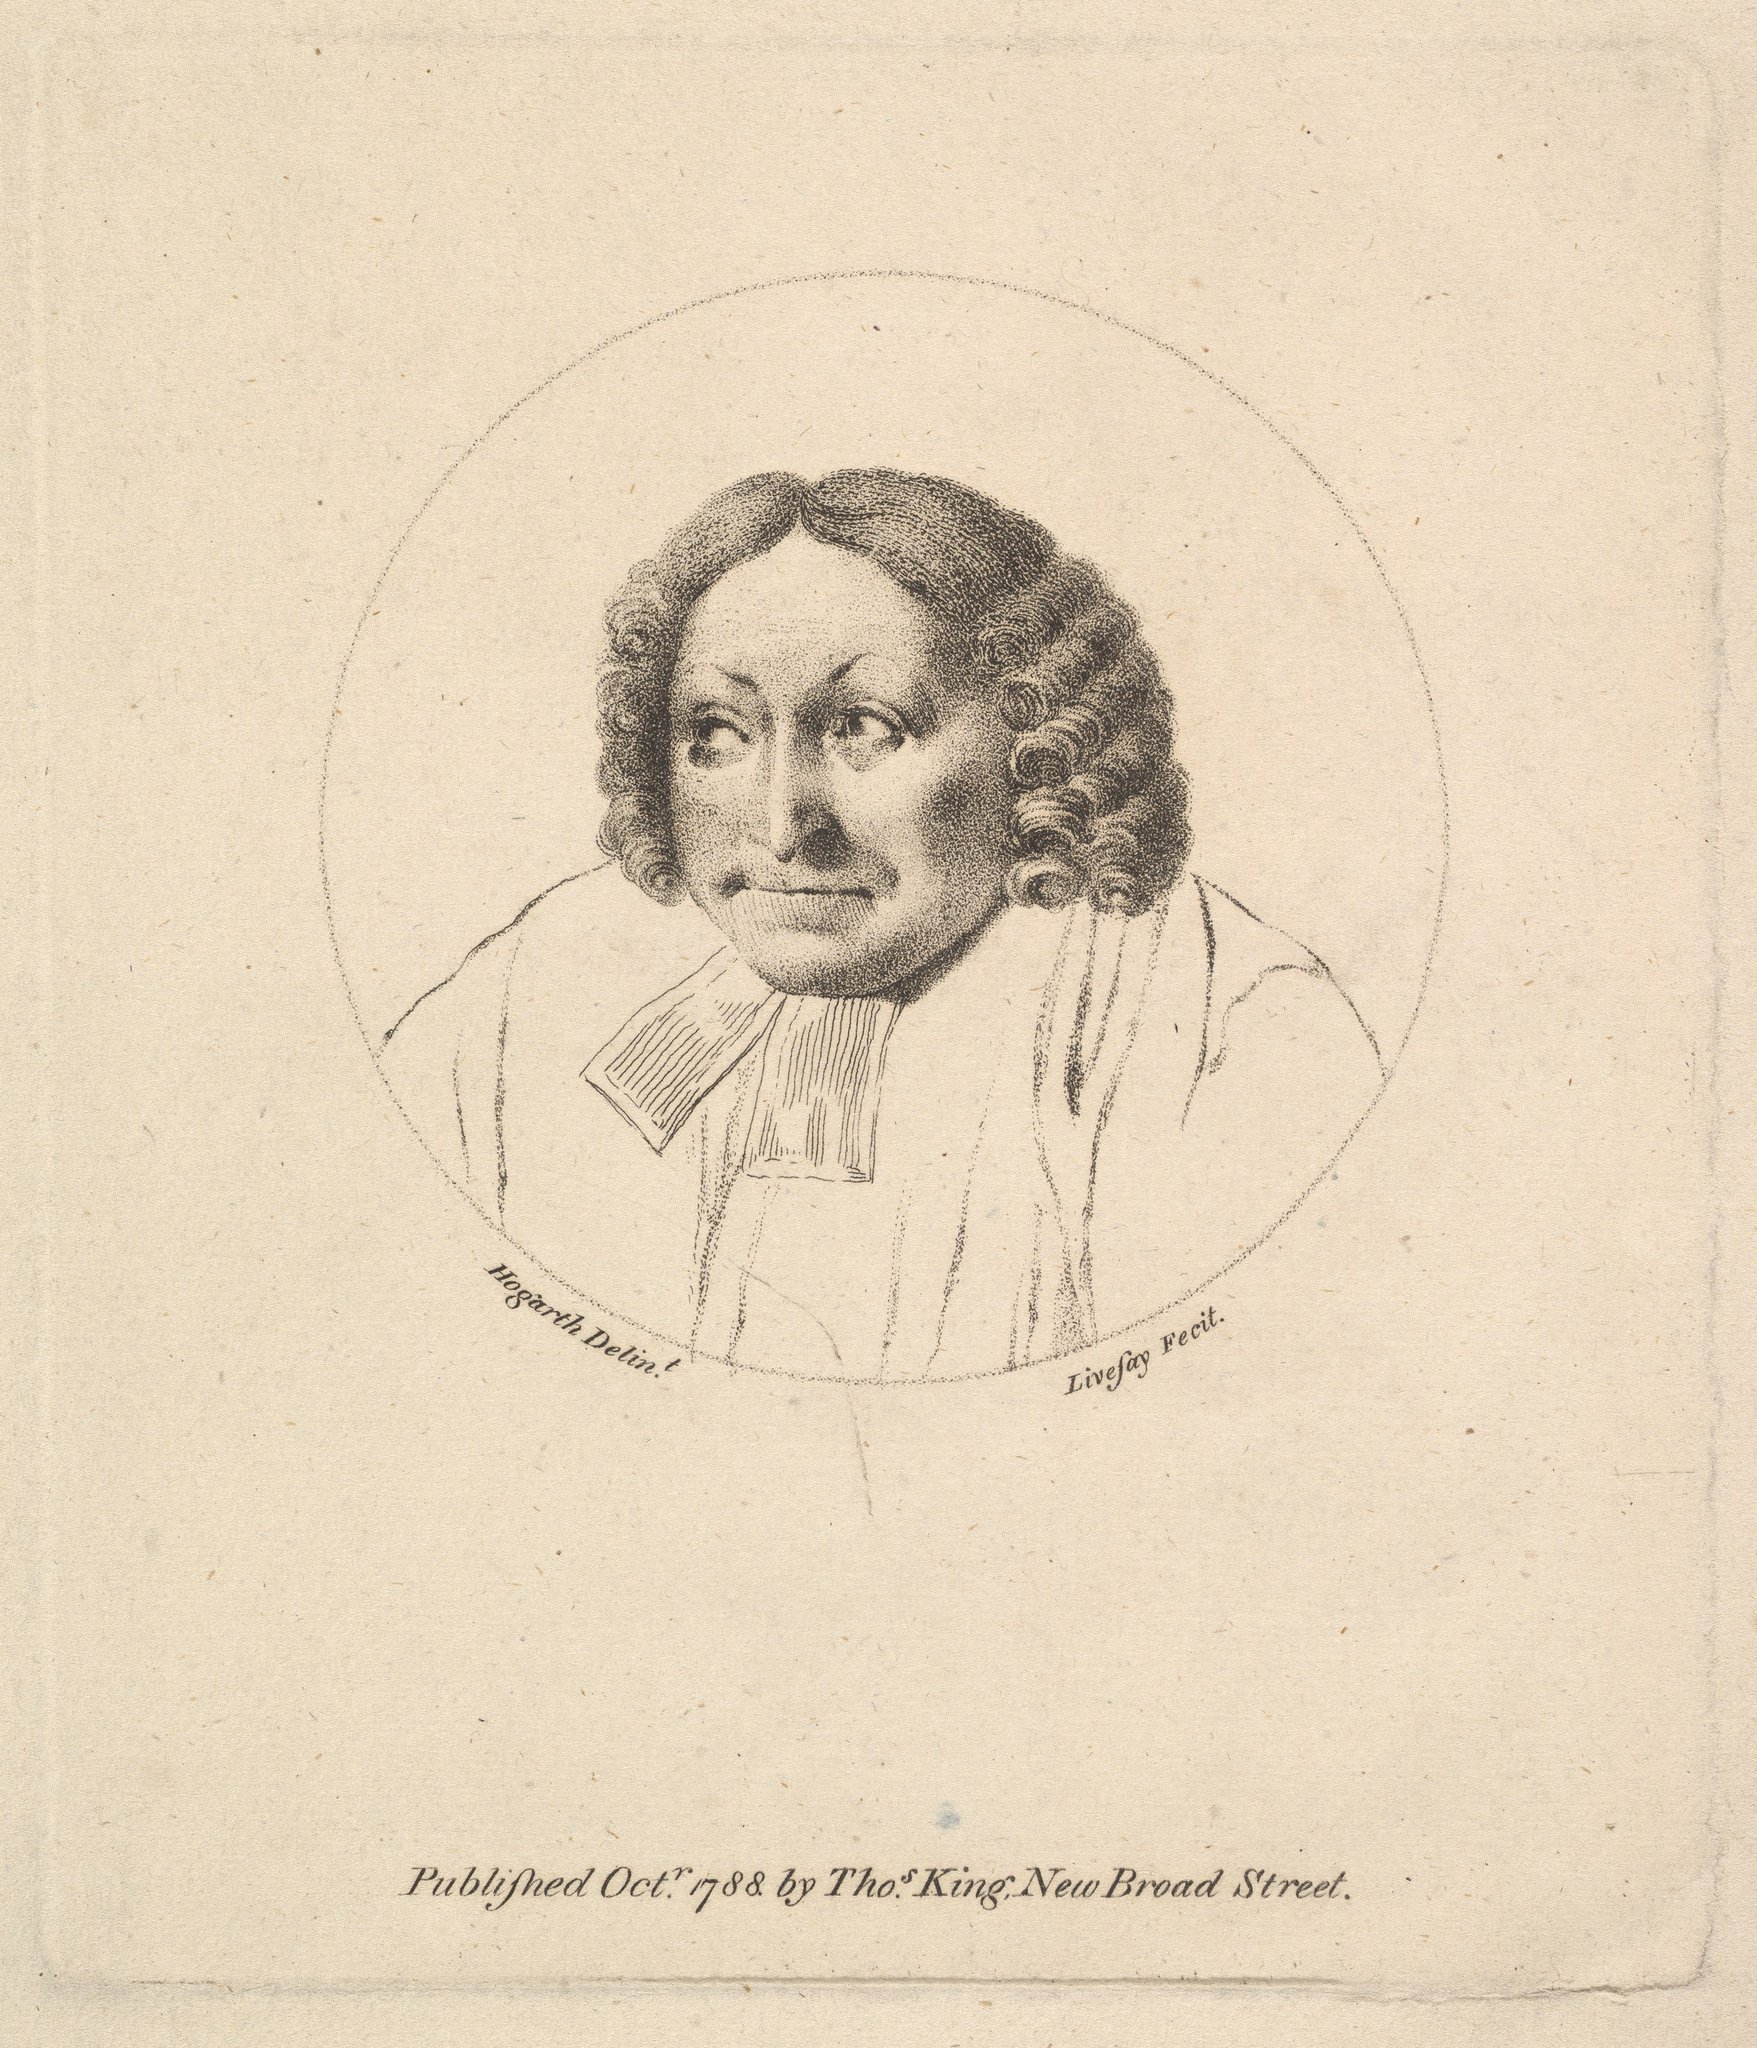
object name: print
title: The Parson's Head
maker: richard livesay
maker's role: etcher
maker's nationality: british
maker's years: 1750-1826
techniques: engraving, etching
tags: heads,men